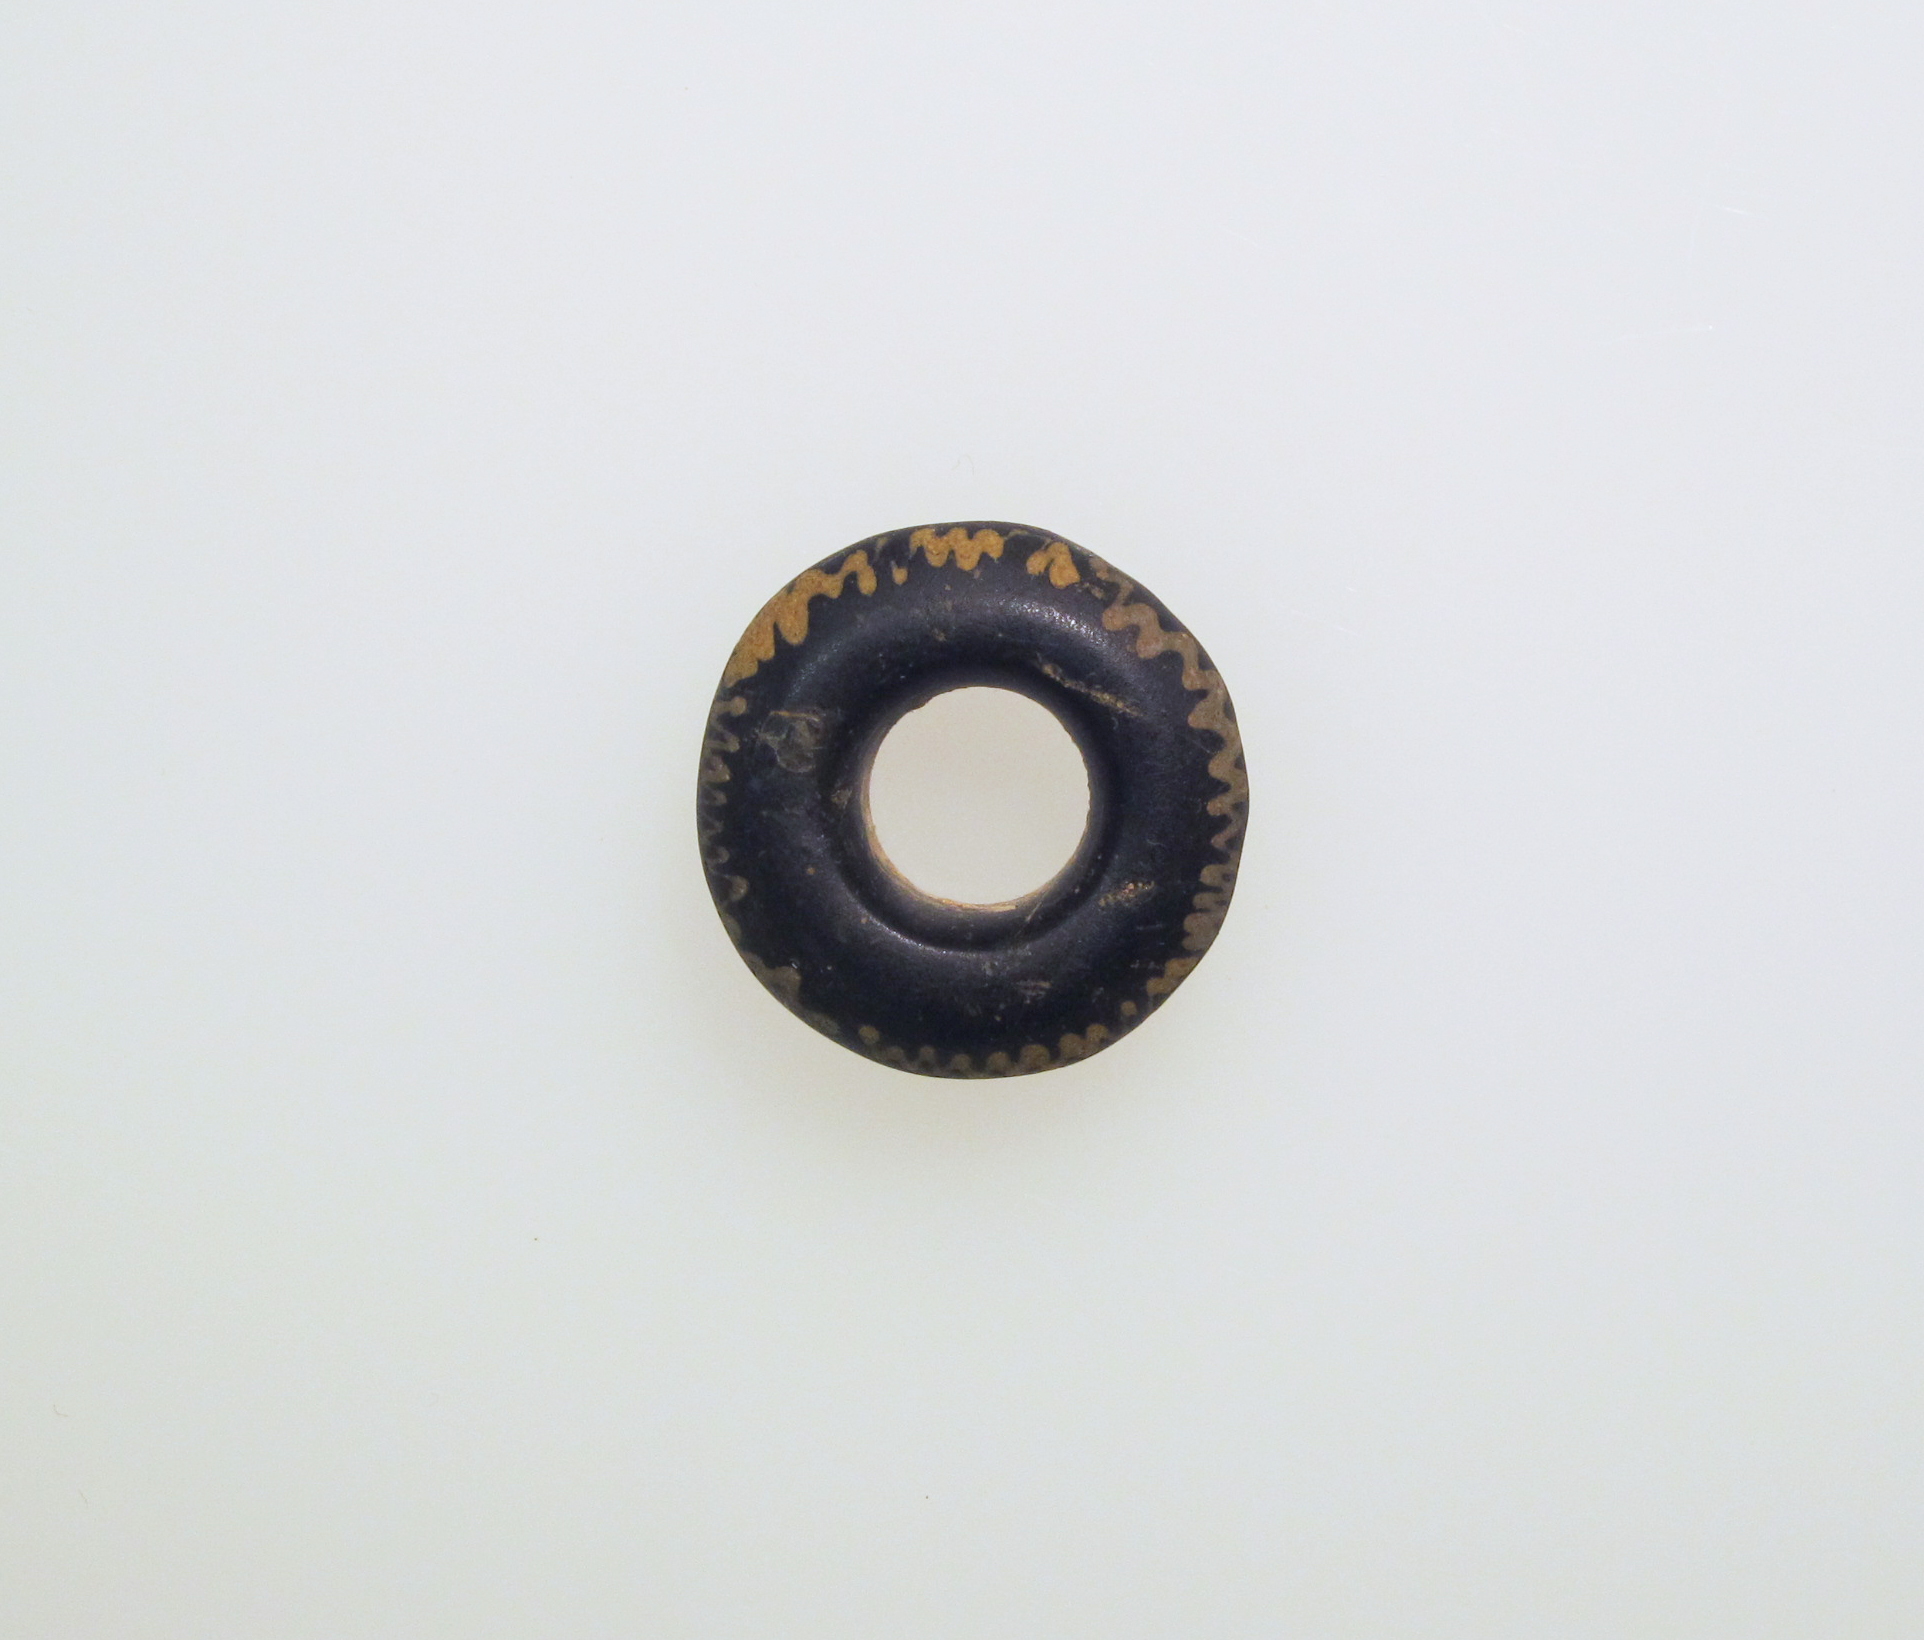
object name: bead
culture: roman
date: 670 BCE-330 CE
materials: glass